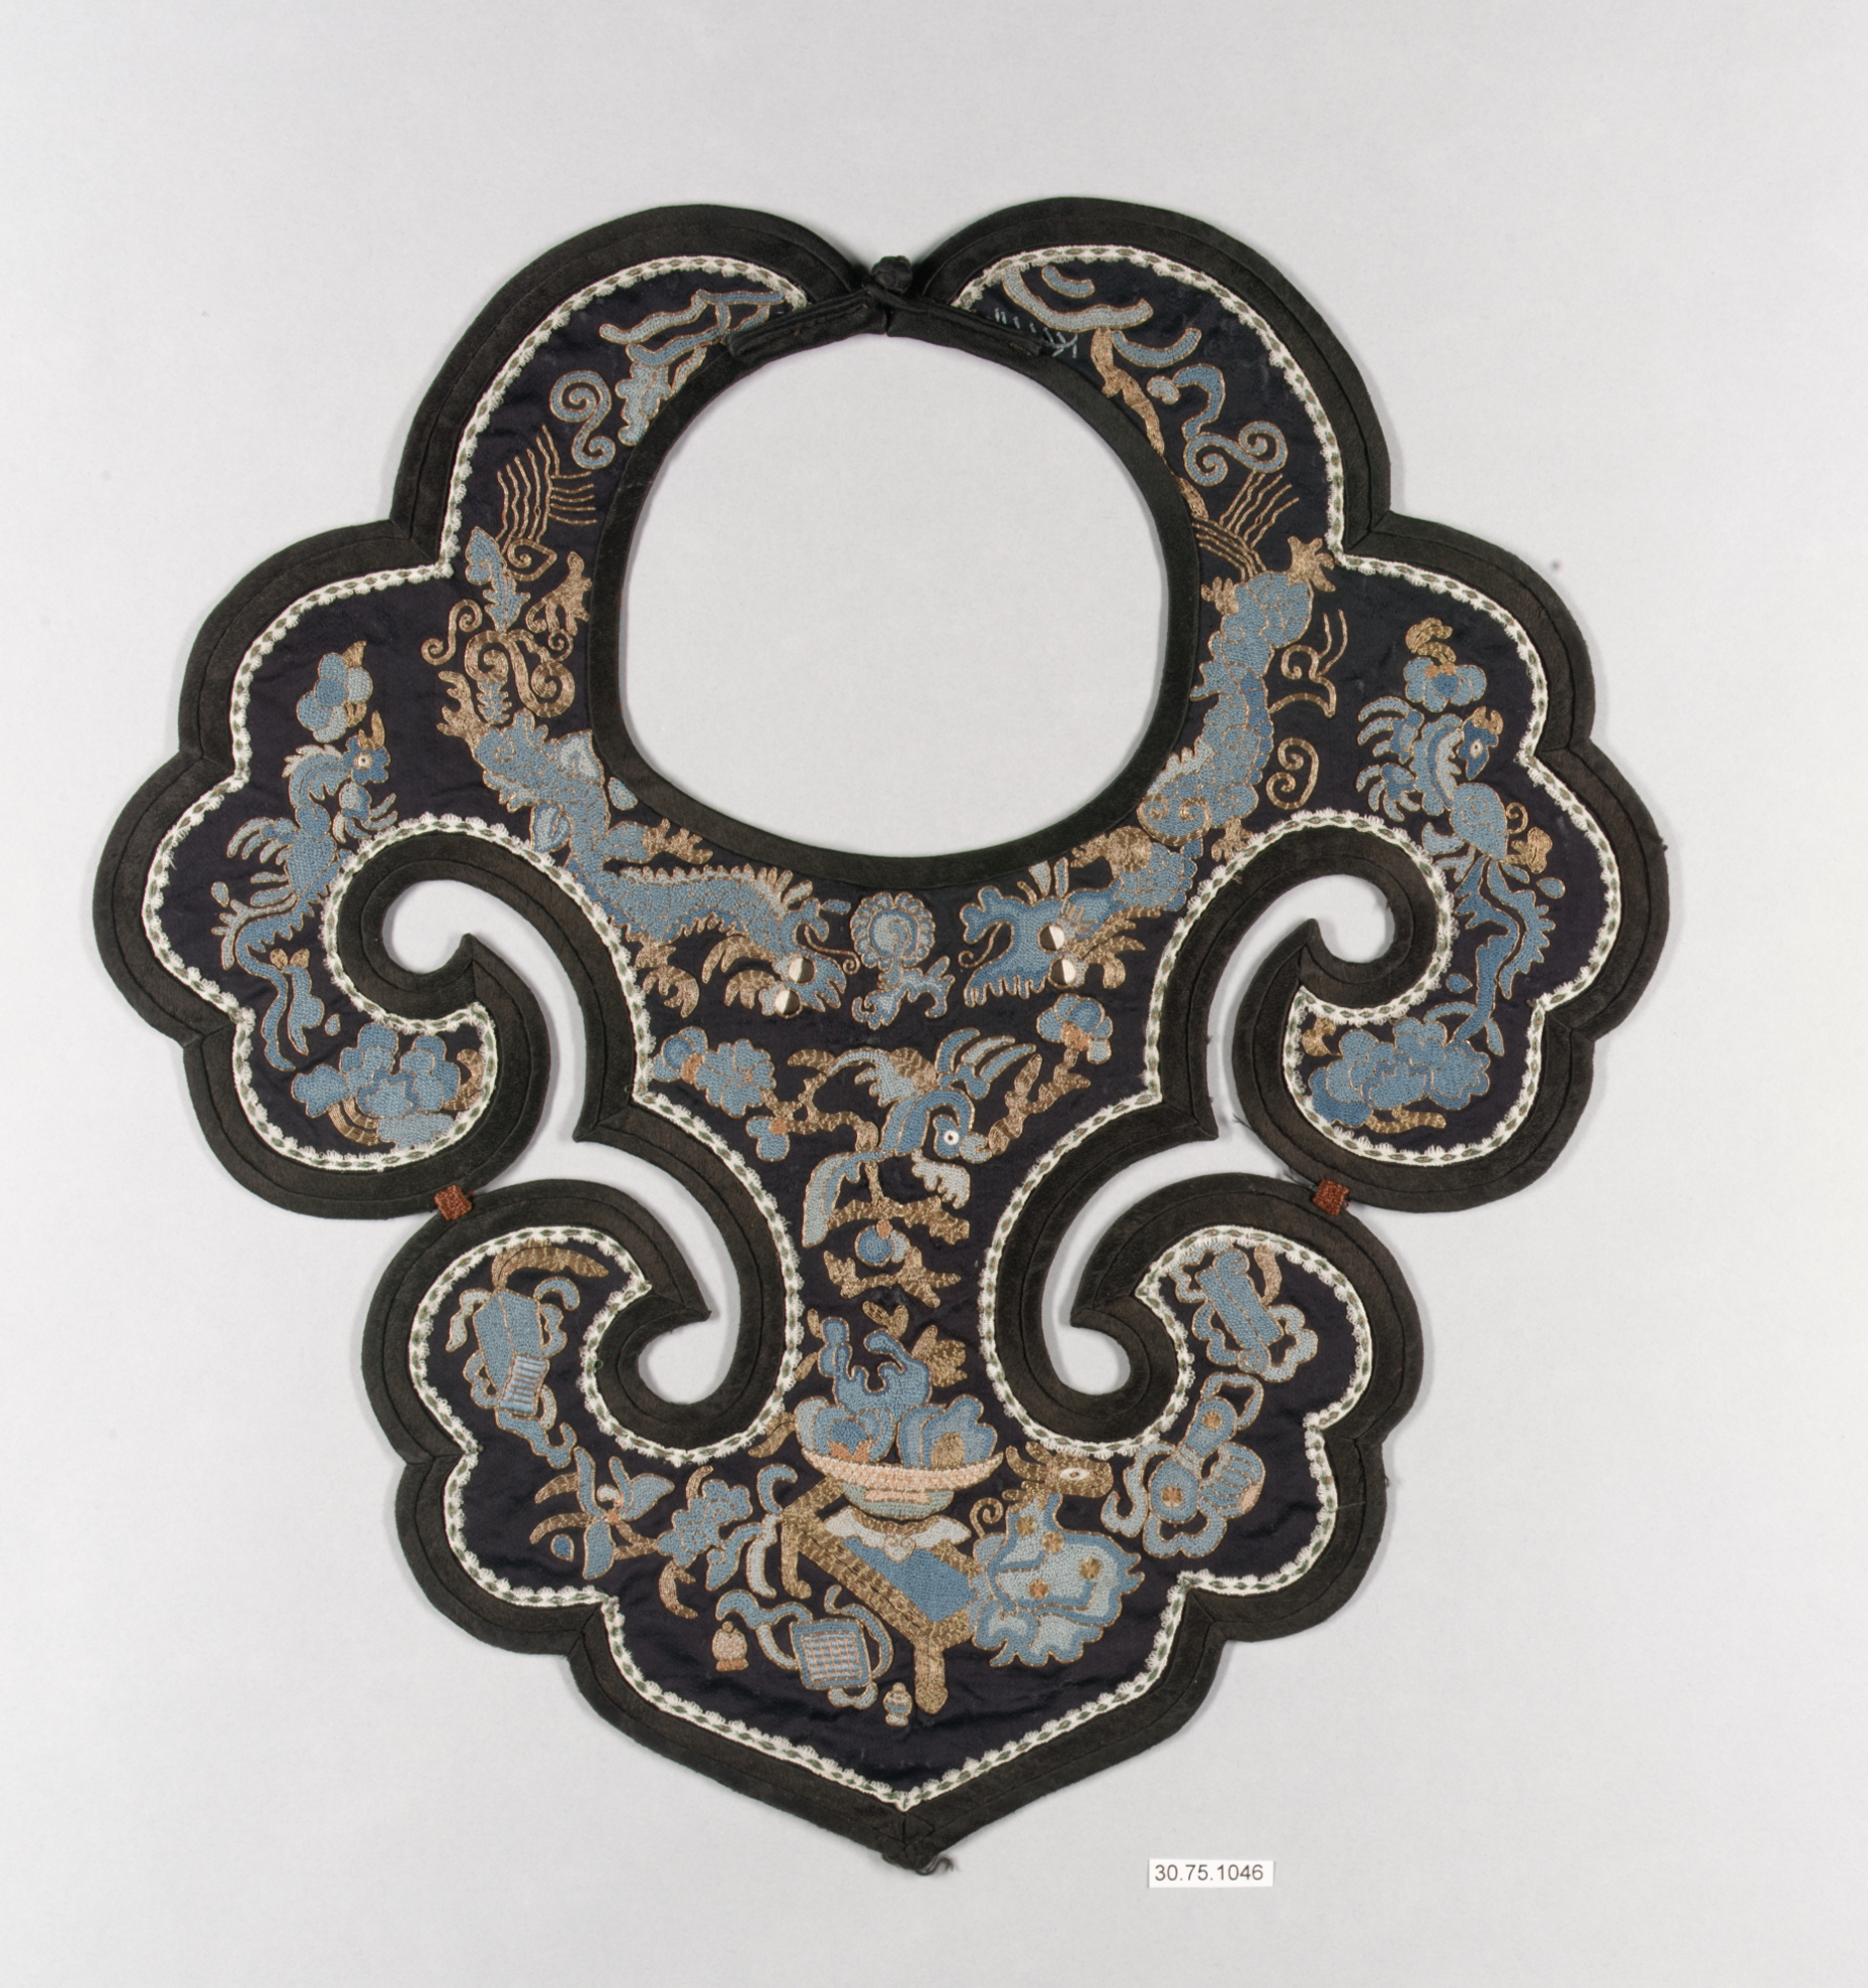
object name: collar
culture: chinese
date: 1801-1900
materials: metal thread, silk